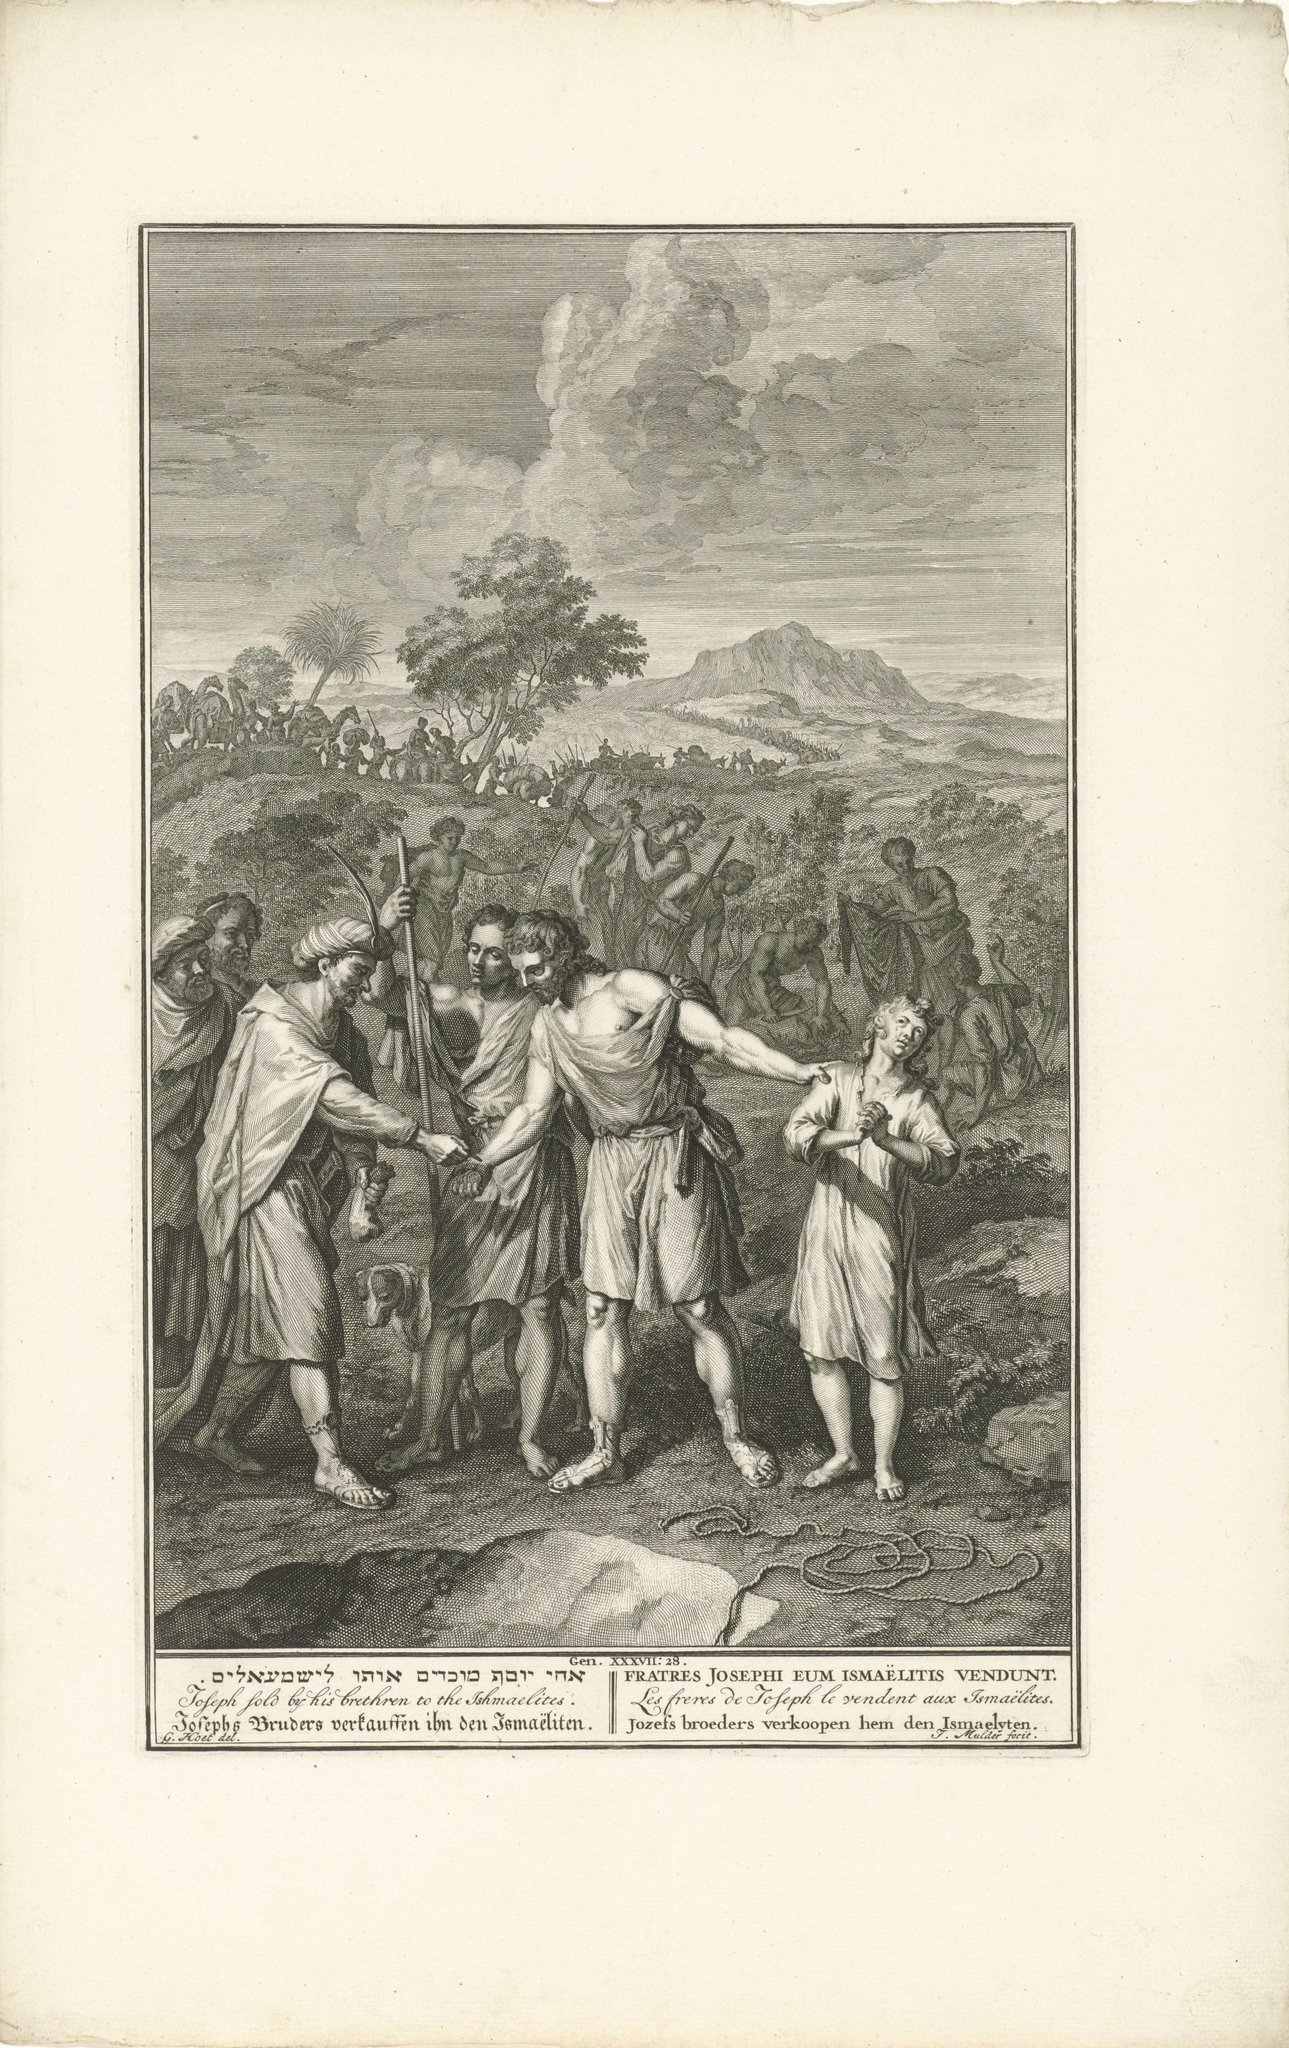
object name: book illustration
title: Jozef door zijn broers verkocht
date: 1720-1728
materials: paper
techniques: engraving, etching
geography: amsterdam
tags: joseph is sold for twenty pieces of silver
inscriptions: inscription: ‘Utrechts Fundatie huijs’, collector's mark: Lugt 2228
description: Jozef wordt door zijn broers verkocht aan een groep Ismaëlieten. Op de voorgrond de put, waarin zijn broers hem gevangen hielden. Op de achtergrond wordt een bok geslacht om de jas van Jozef te kunnen besmeuren met bloed, zodat zijn vader zal geloven dat Jozef verscheurd is door wilde dieren. Onderaan in de marge een verwijzing naar de Bijbeltekst en de titel in het Hebreeuws, Engels, Duits, Latijn, Frans en Nederlands.